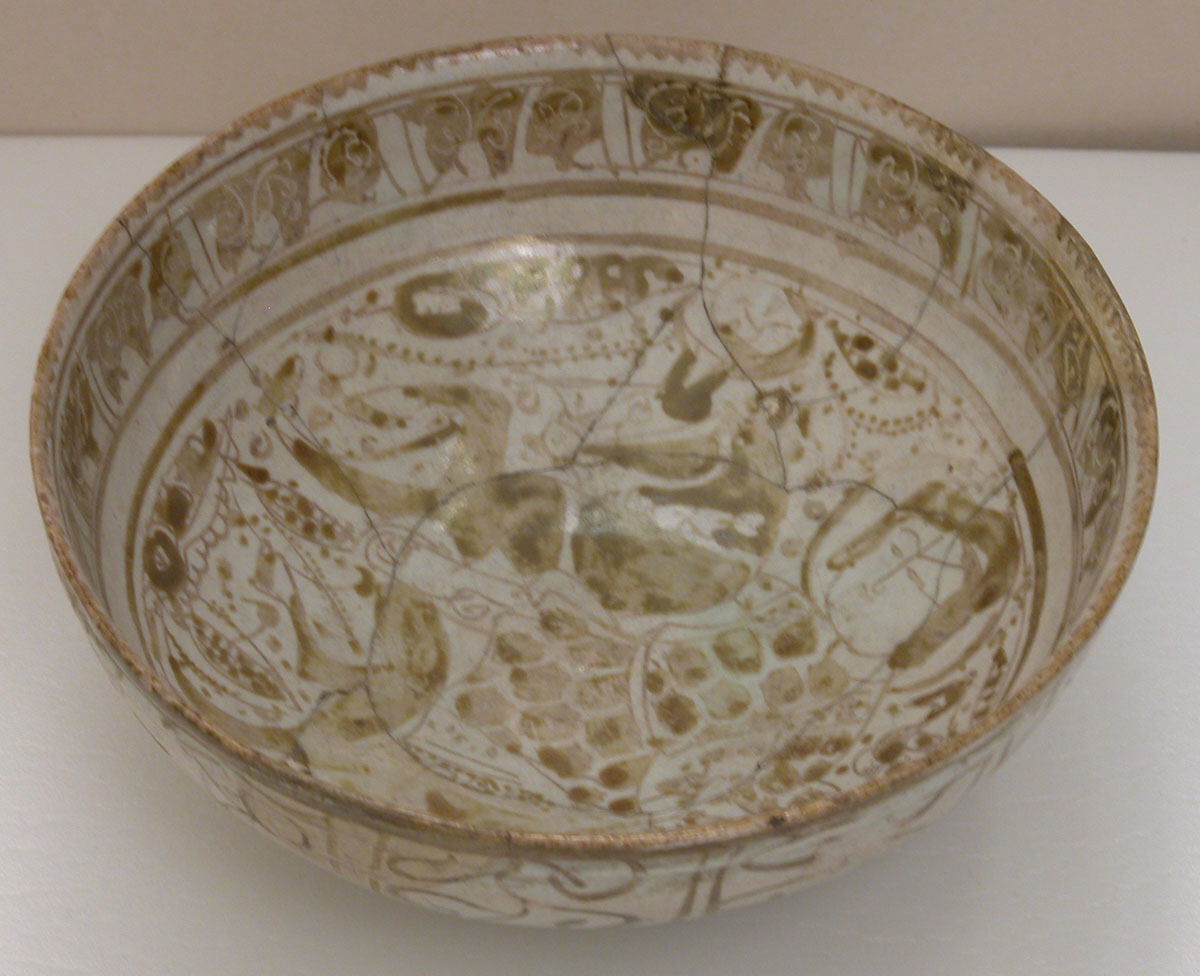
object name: bowl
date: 1101-1300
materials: stonepaste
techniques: glazing, luster painting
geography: iran